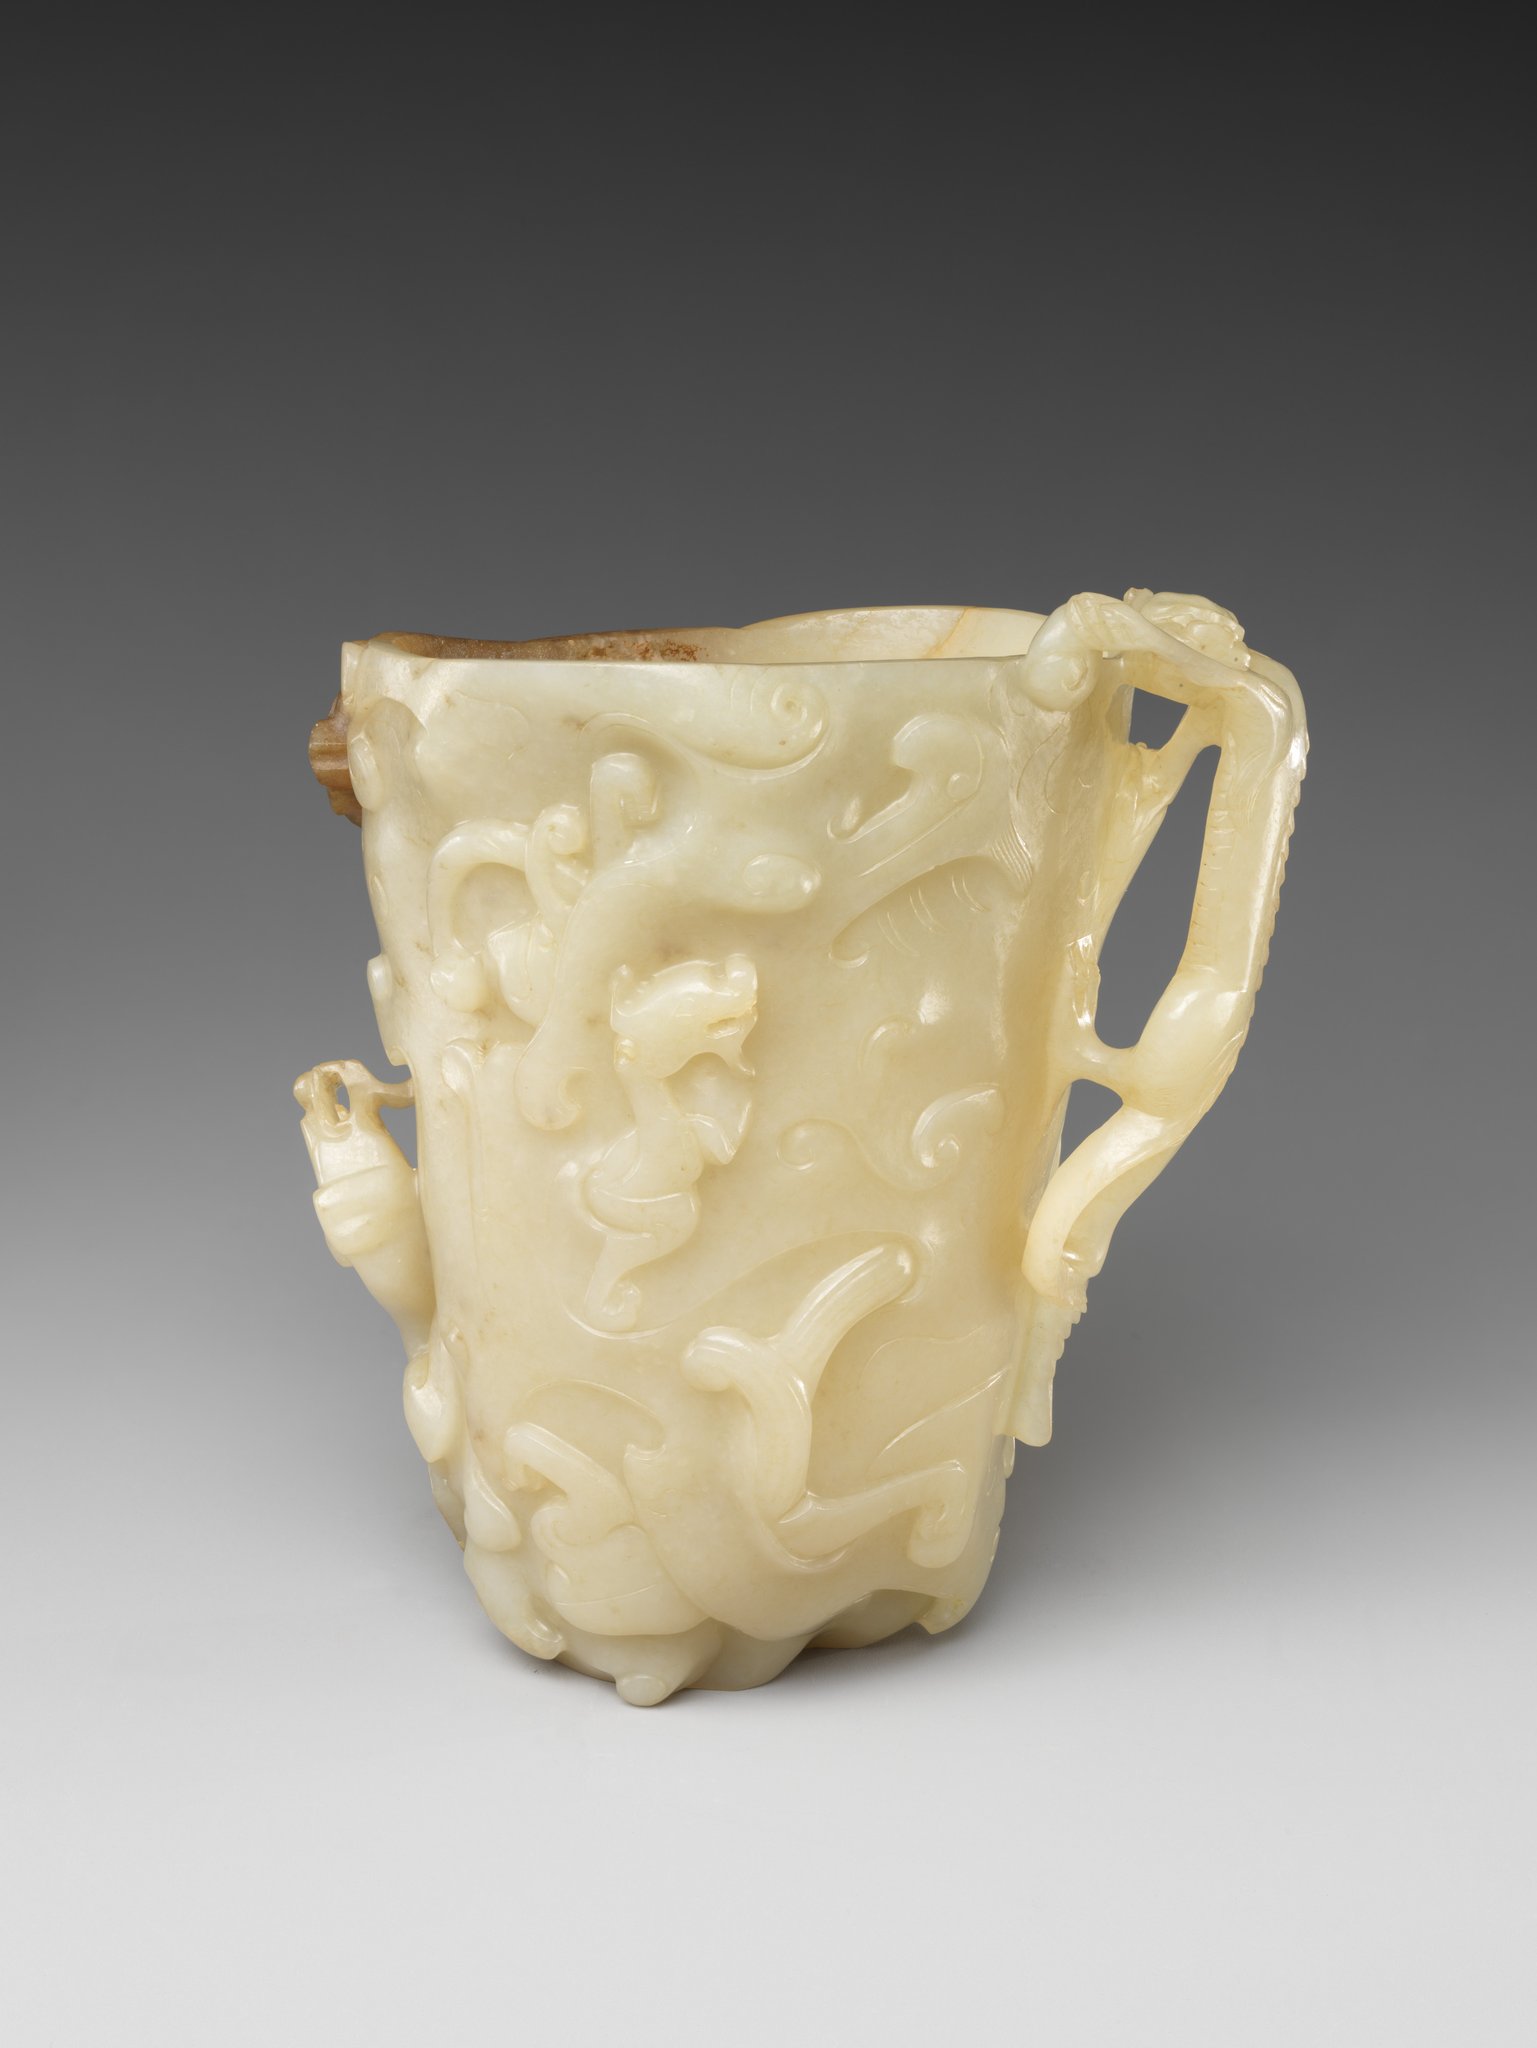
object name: libation cup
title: Libation cup with chi dragons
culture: chinese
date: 1501-1700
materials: jade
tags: dragons